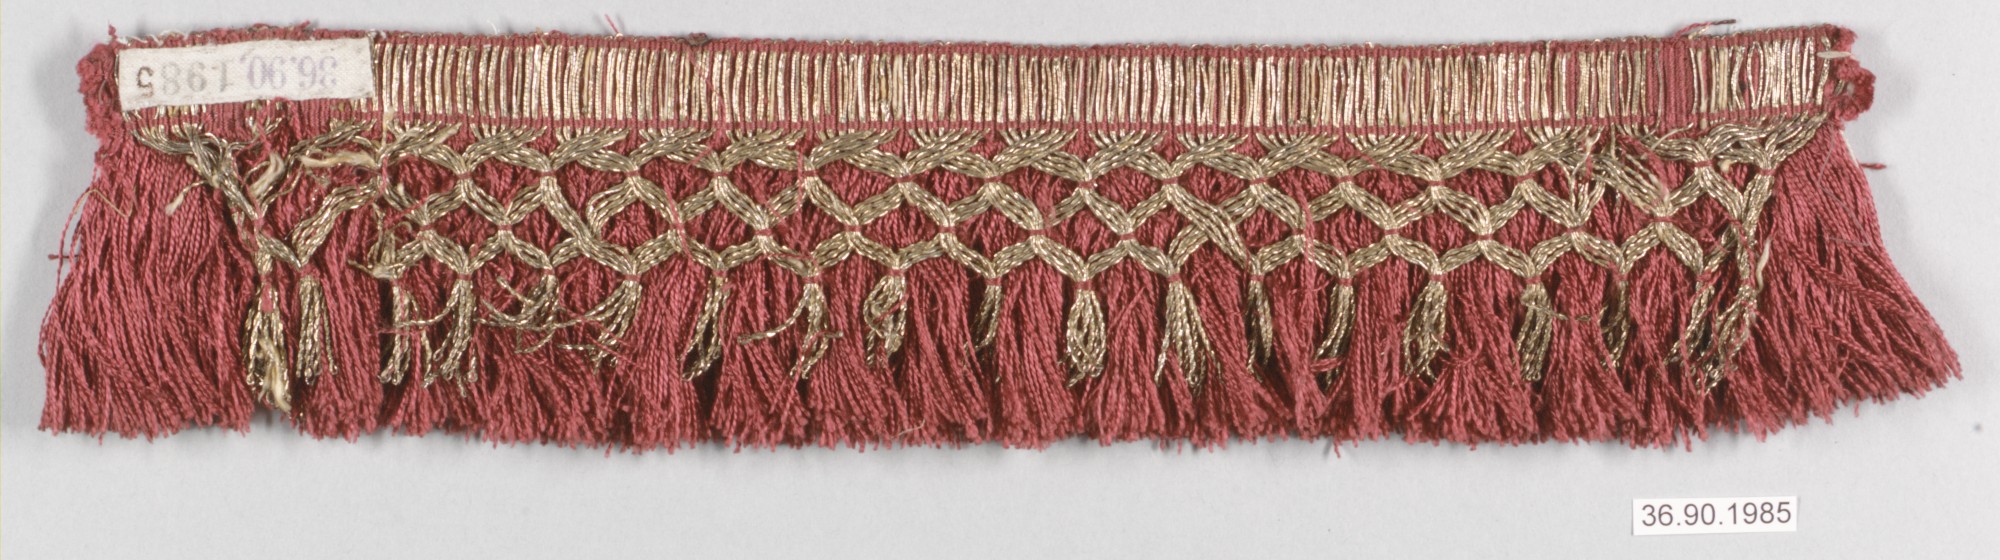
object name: fringe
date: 1750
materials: metal thread, silk